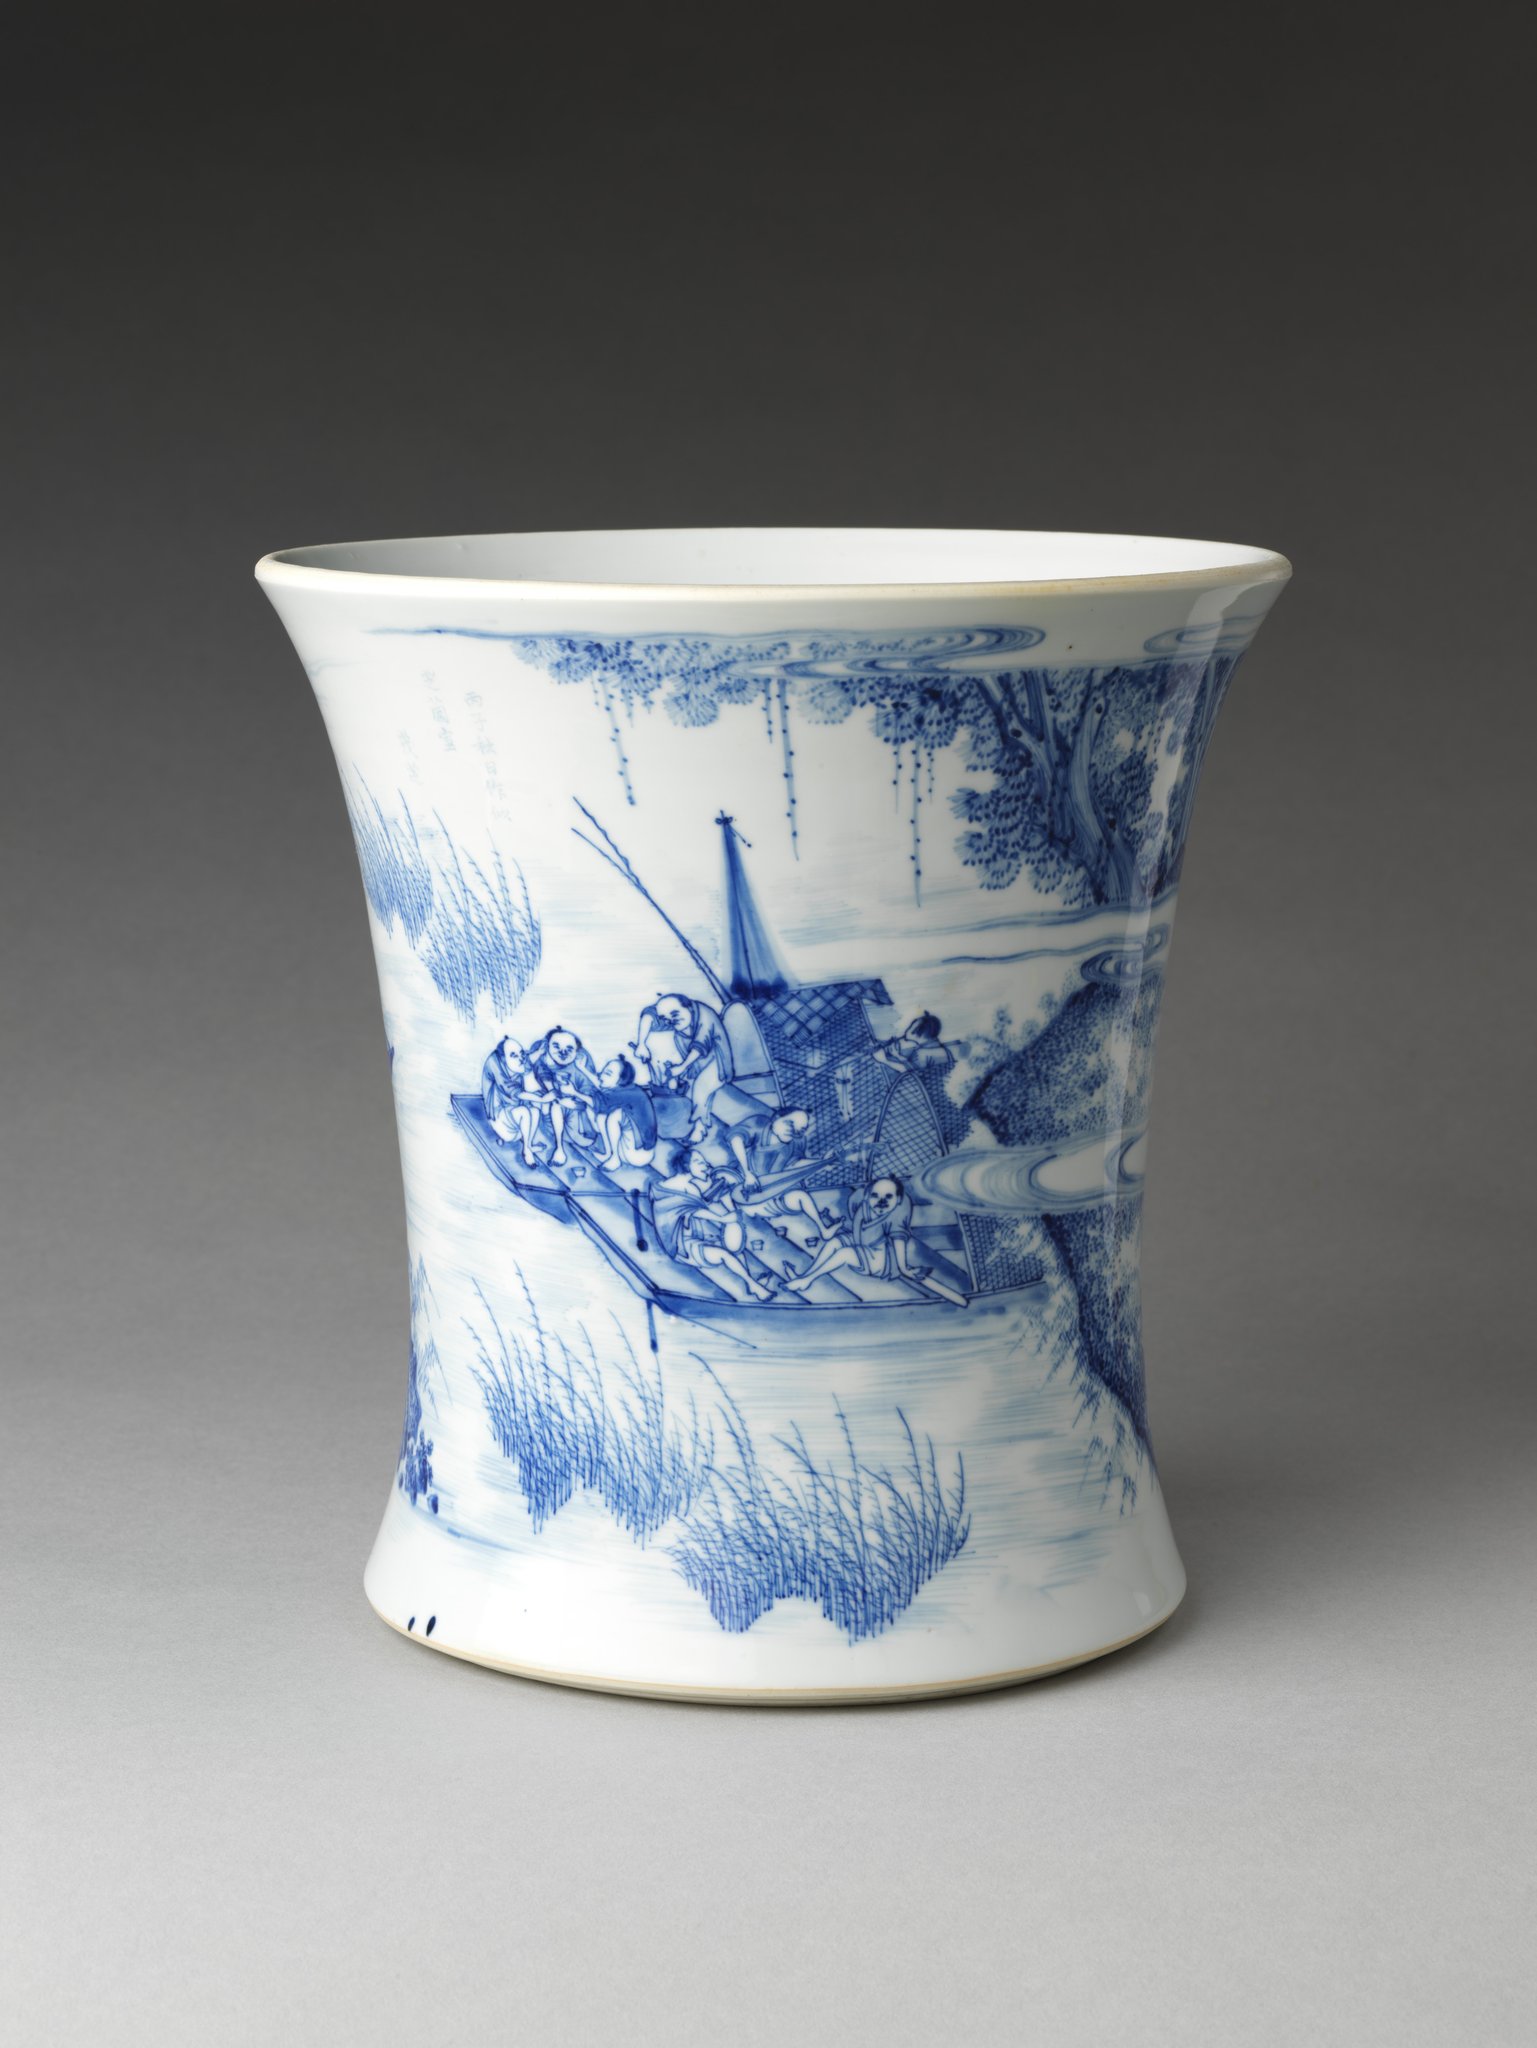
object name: brush holder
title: Brush holder with scene of Wang Qing crossing the river from The Water Margin (Shuihu zhuan)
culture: chinese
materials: cobalt, porcelain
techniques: painting, underglaze